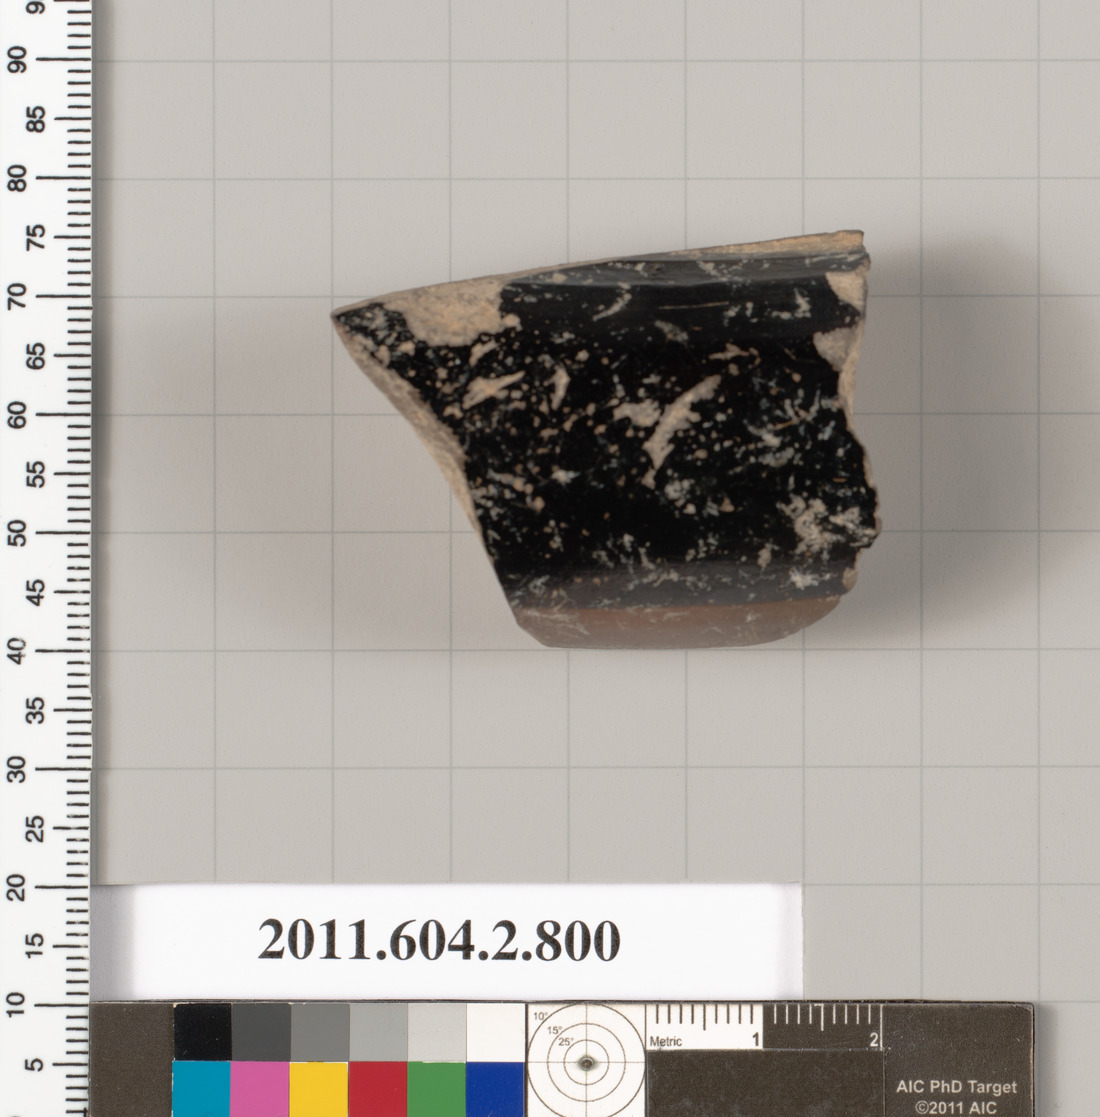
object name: calyx krater fragment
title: Terracotta fragment of a calyx-krater (bowl for mixing wine and water)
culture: greek, attic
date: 700-601 BCE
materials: terracotta